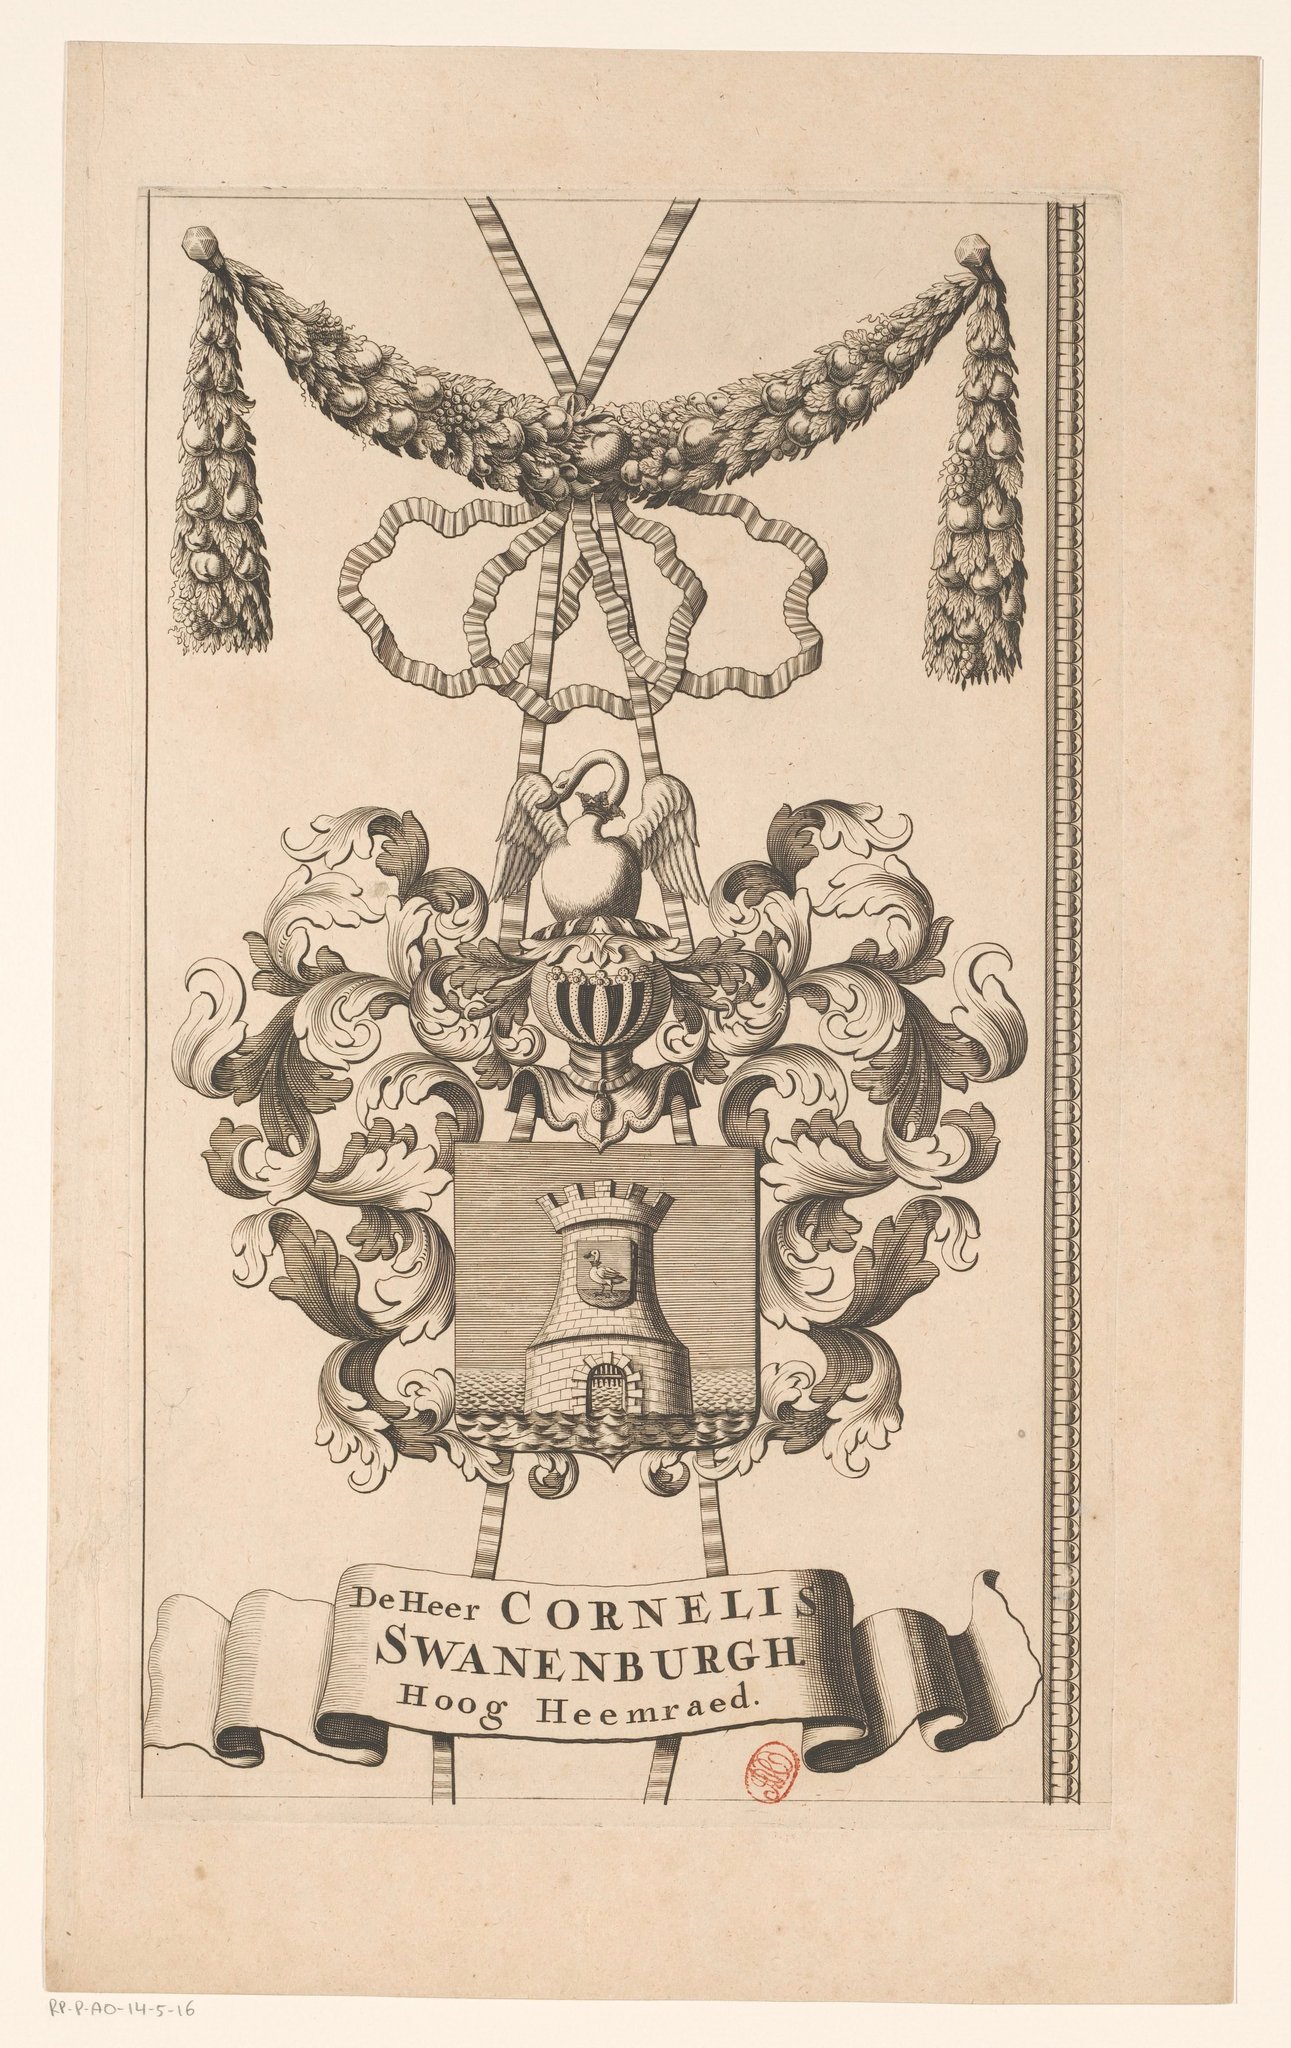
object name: print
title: Kaart van het Hoogheemraadschap van de Krimpenerwaard (deel wapenrand)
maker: Anonymous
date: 1683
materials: paper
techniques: engraving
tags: armorial bearing, heraldry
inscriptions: collector's mark: Lugt 195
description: Deel van de wapenrand van de derde druk van 'Het Hooge Heemraadschap vande Crimpenre Waard', een wandkaart (bestaande uit een kaart en een wapenrand) van het Hoogheemraadschap van de Krimpenerwaard.